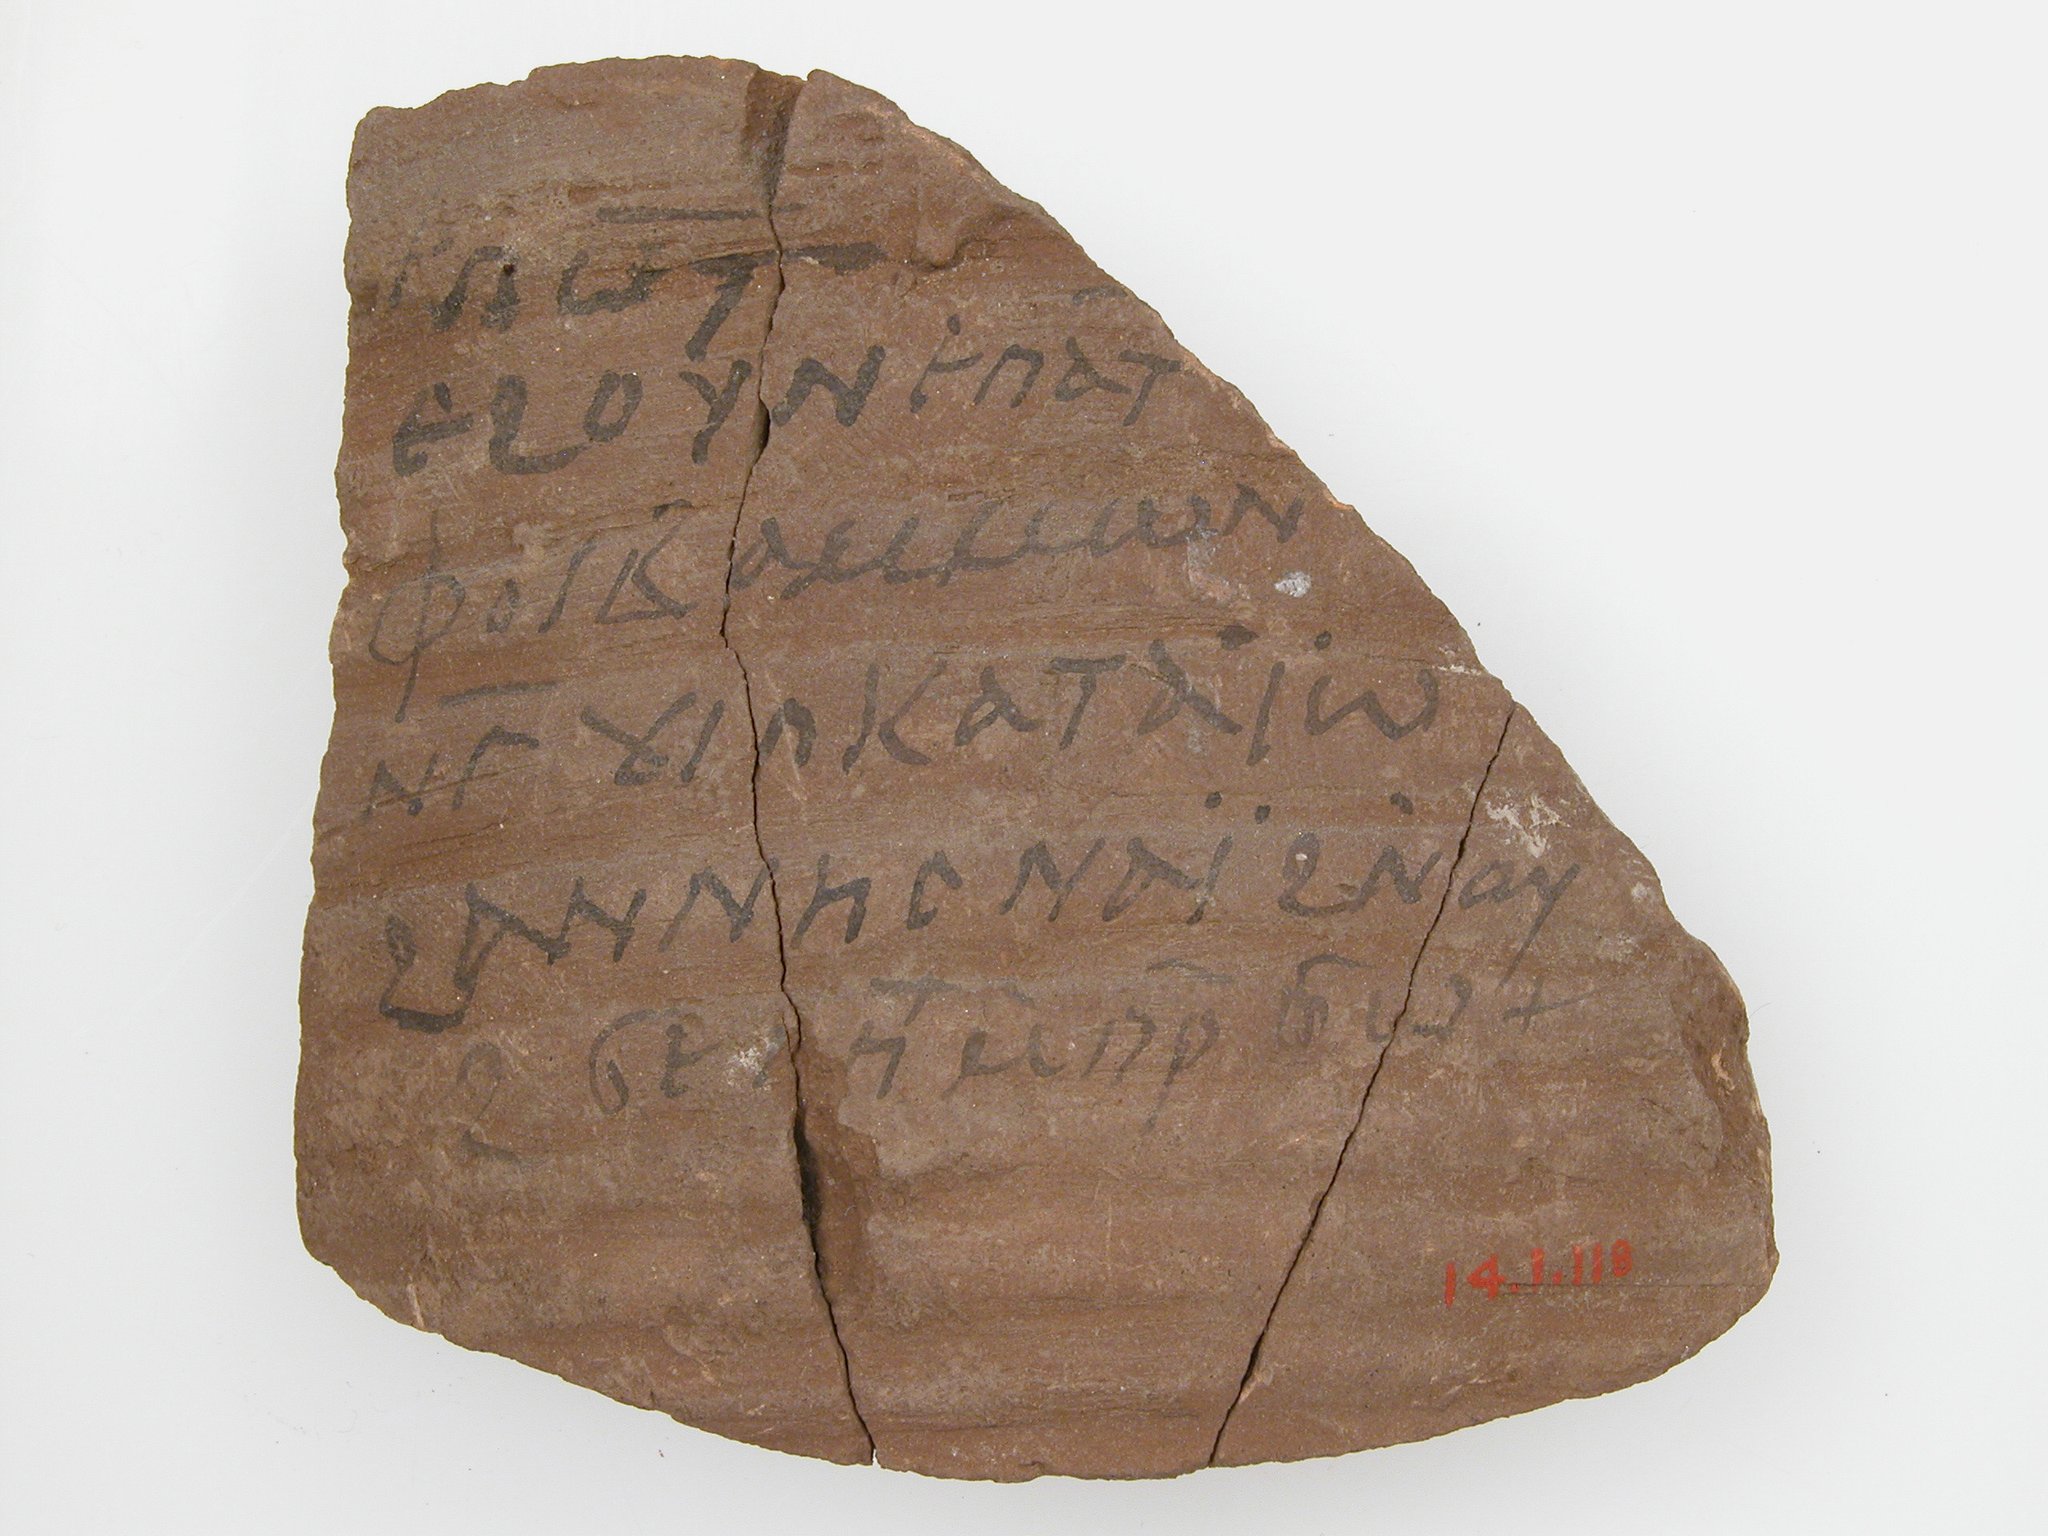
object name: ostrakon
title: Ostrakon with a Letter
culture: coptic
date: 600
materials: ink, pottery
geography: egypt